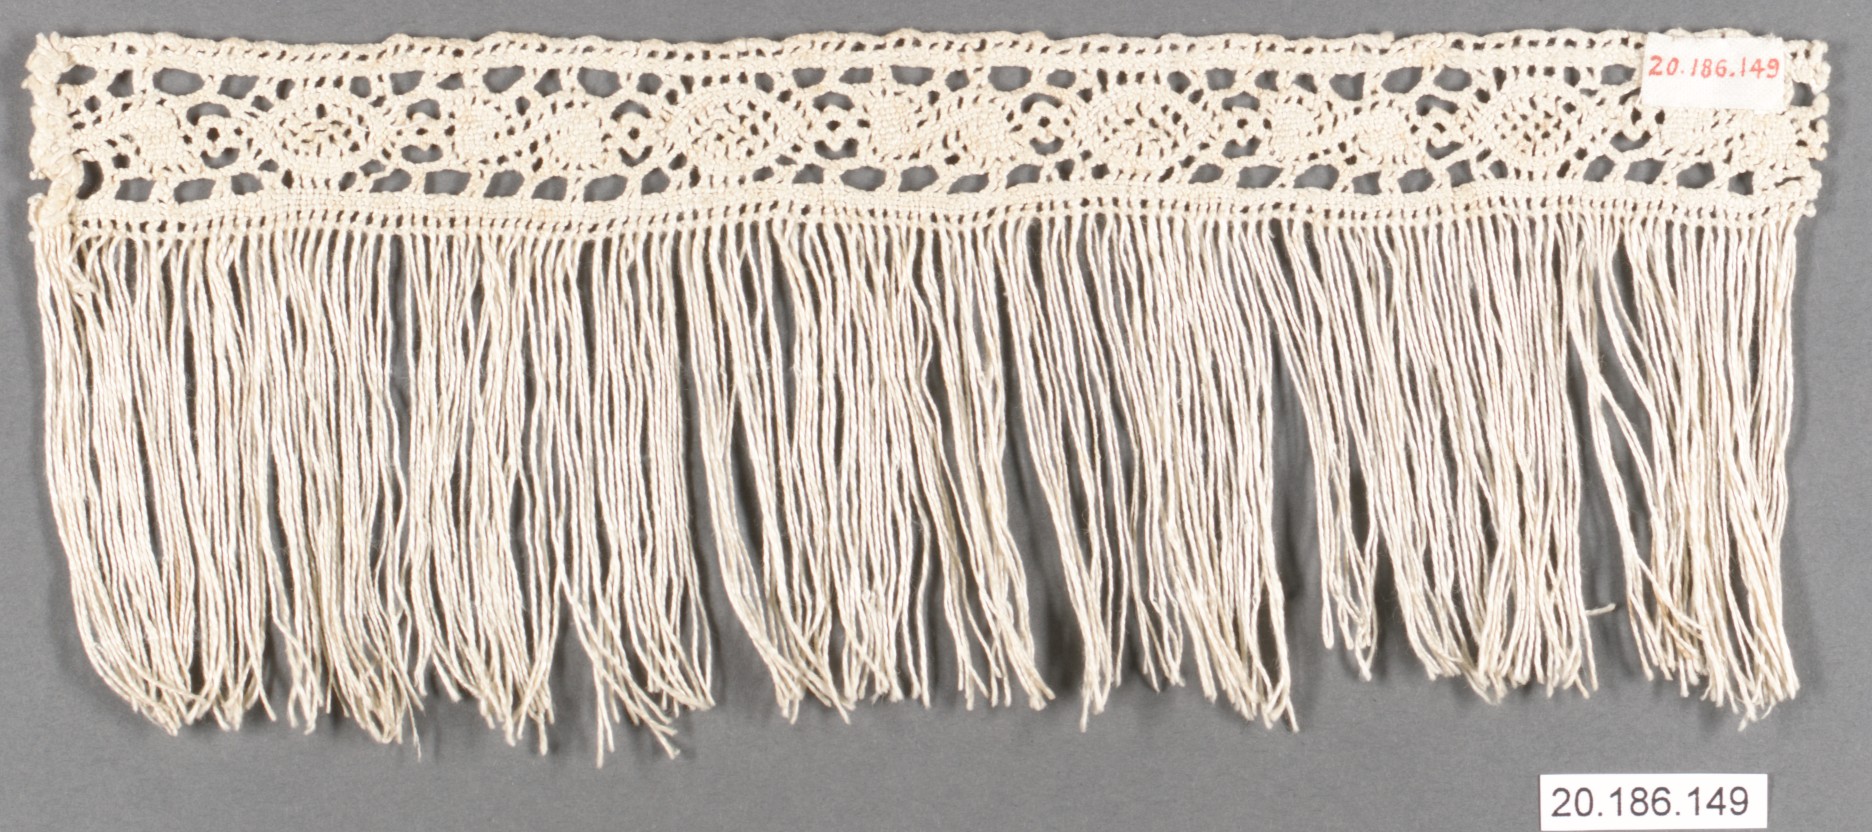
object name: border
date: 1601-1700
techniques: lace